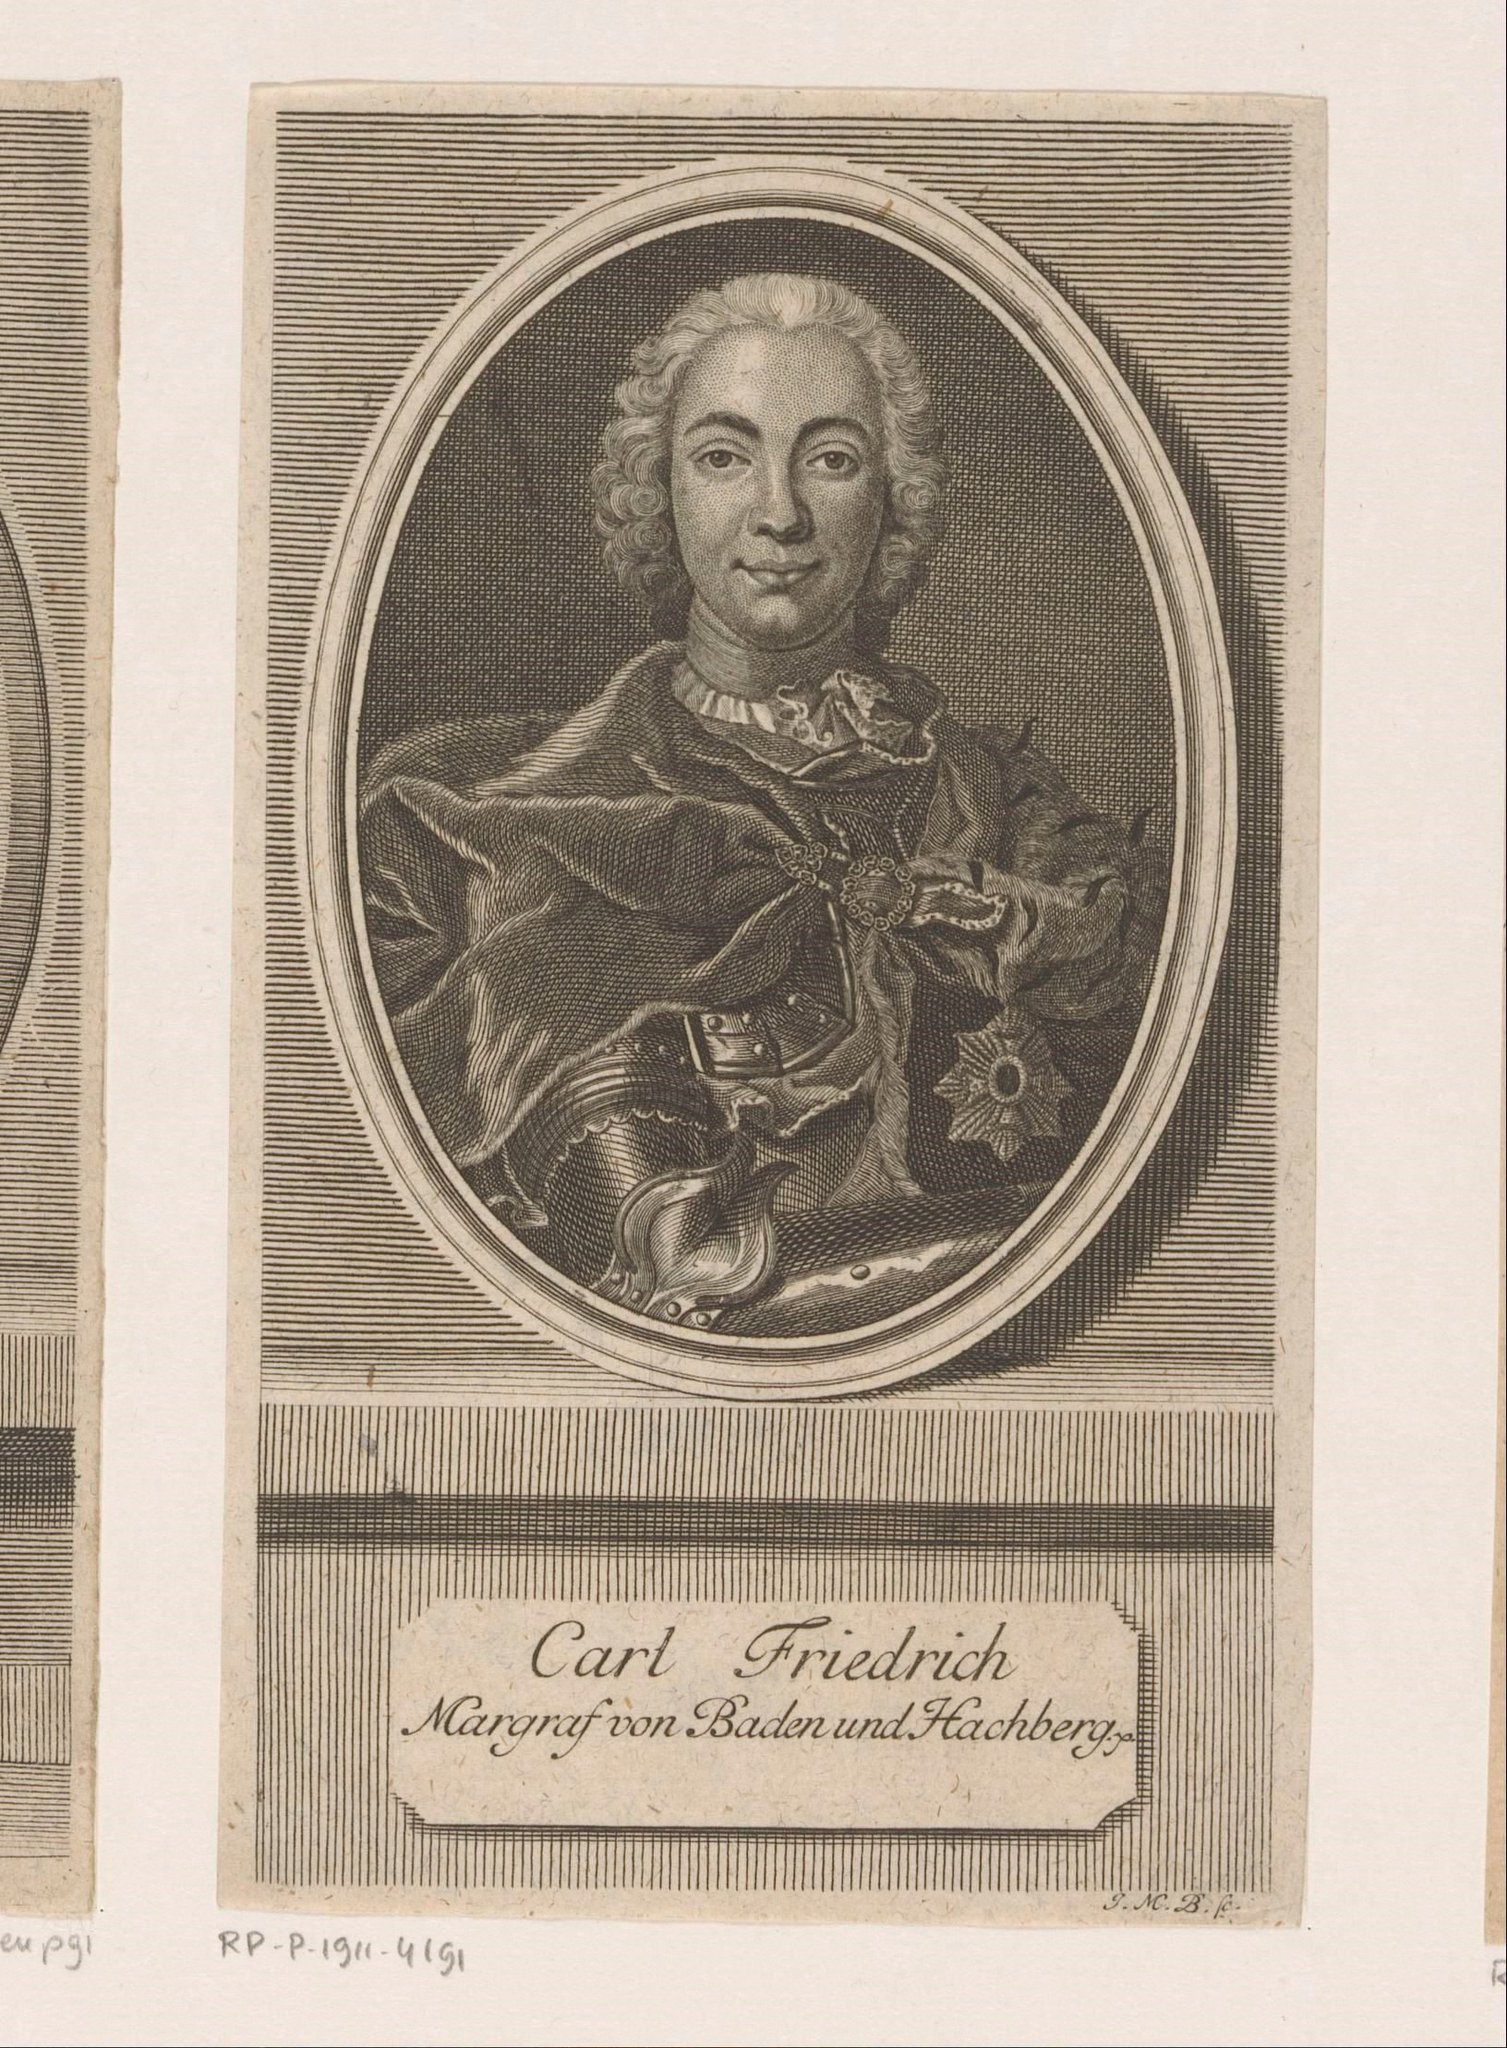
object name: print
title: Portret van Carl Friedrich von Baden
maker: johann martin bernigeroth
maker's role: print maker, publisher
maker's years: 1713-1767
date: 1723-1767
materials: paper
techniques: engraving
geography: leipzig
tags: knighthood order, armour, historical persons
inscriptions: collector's mark: Lugt 2228